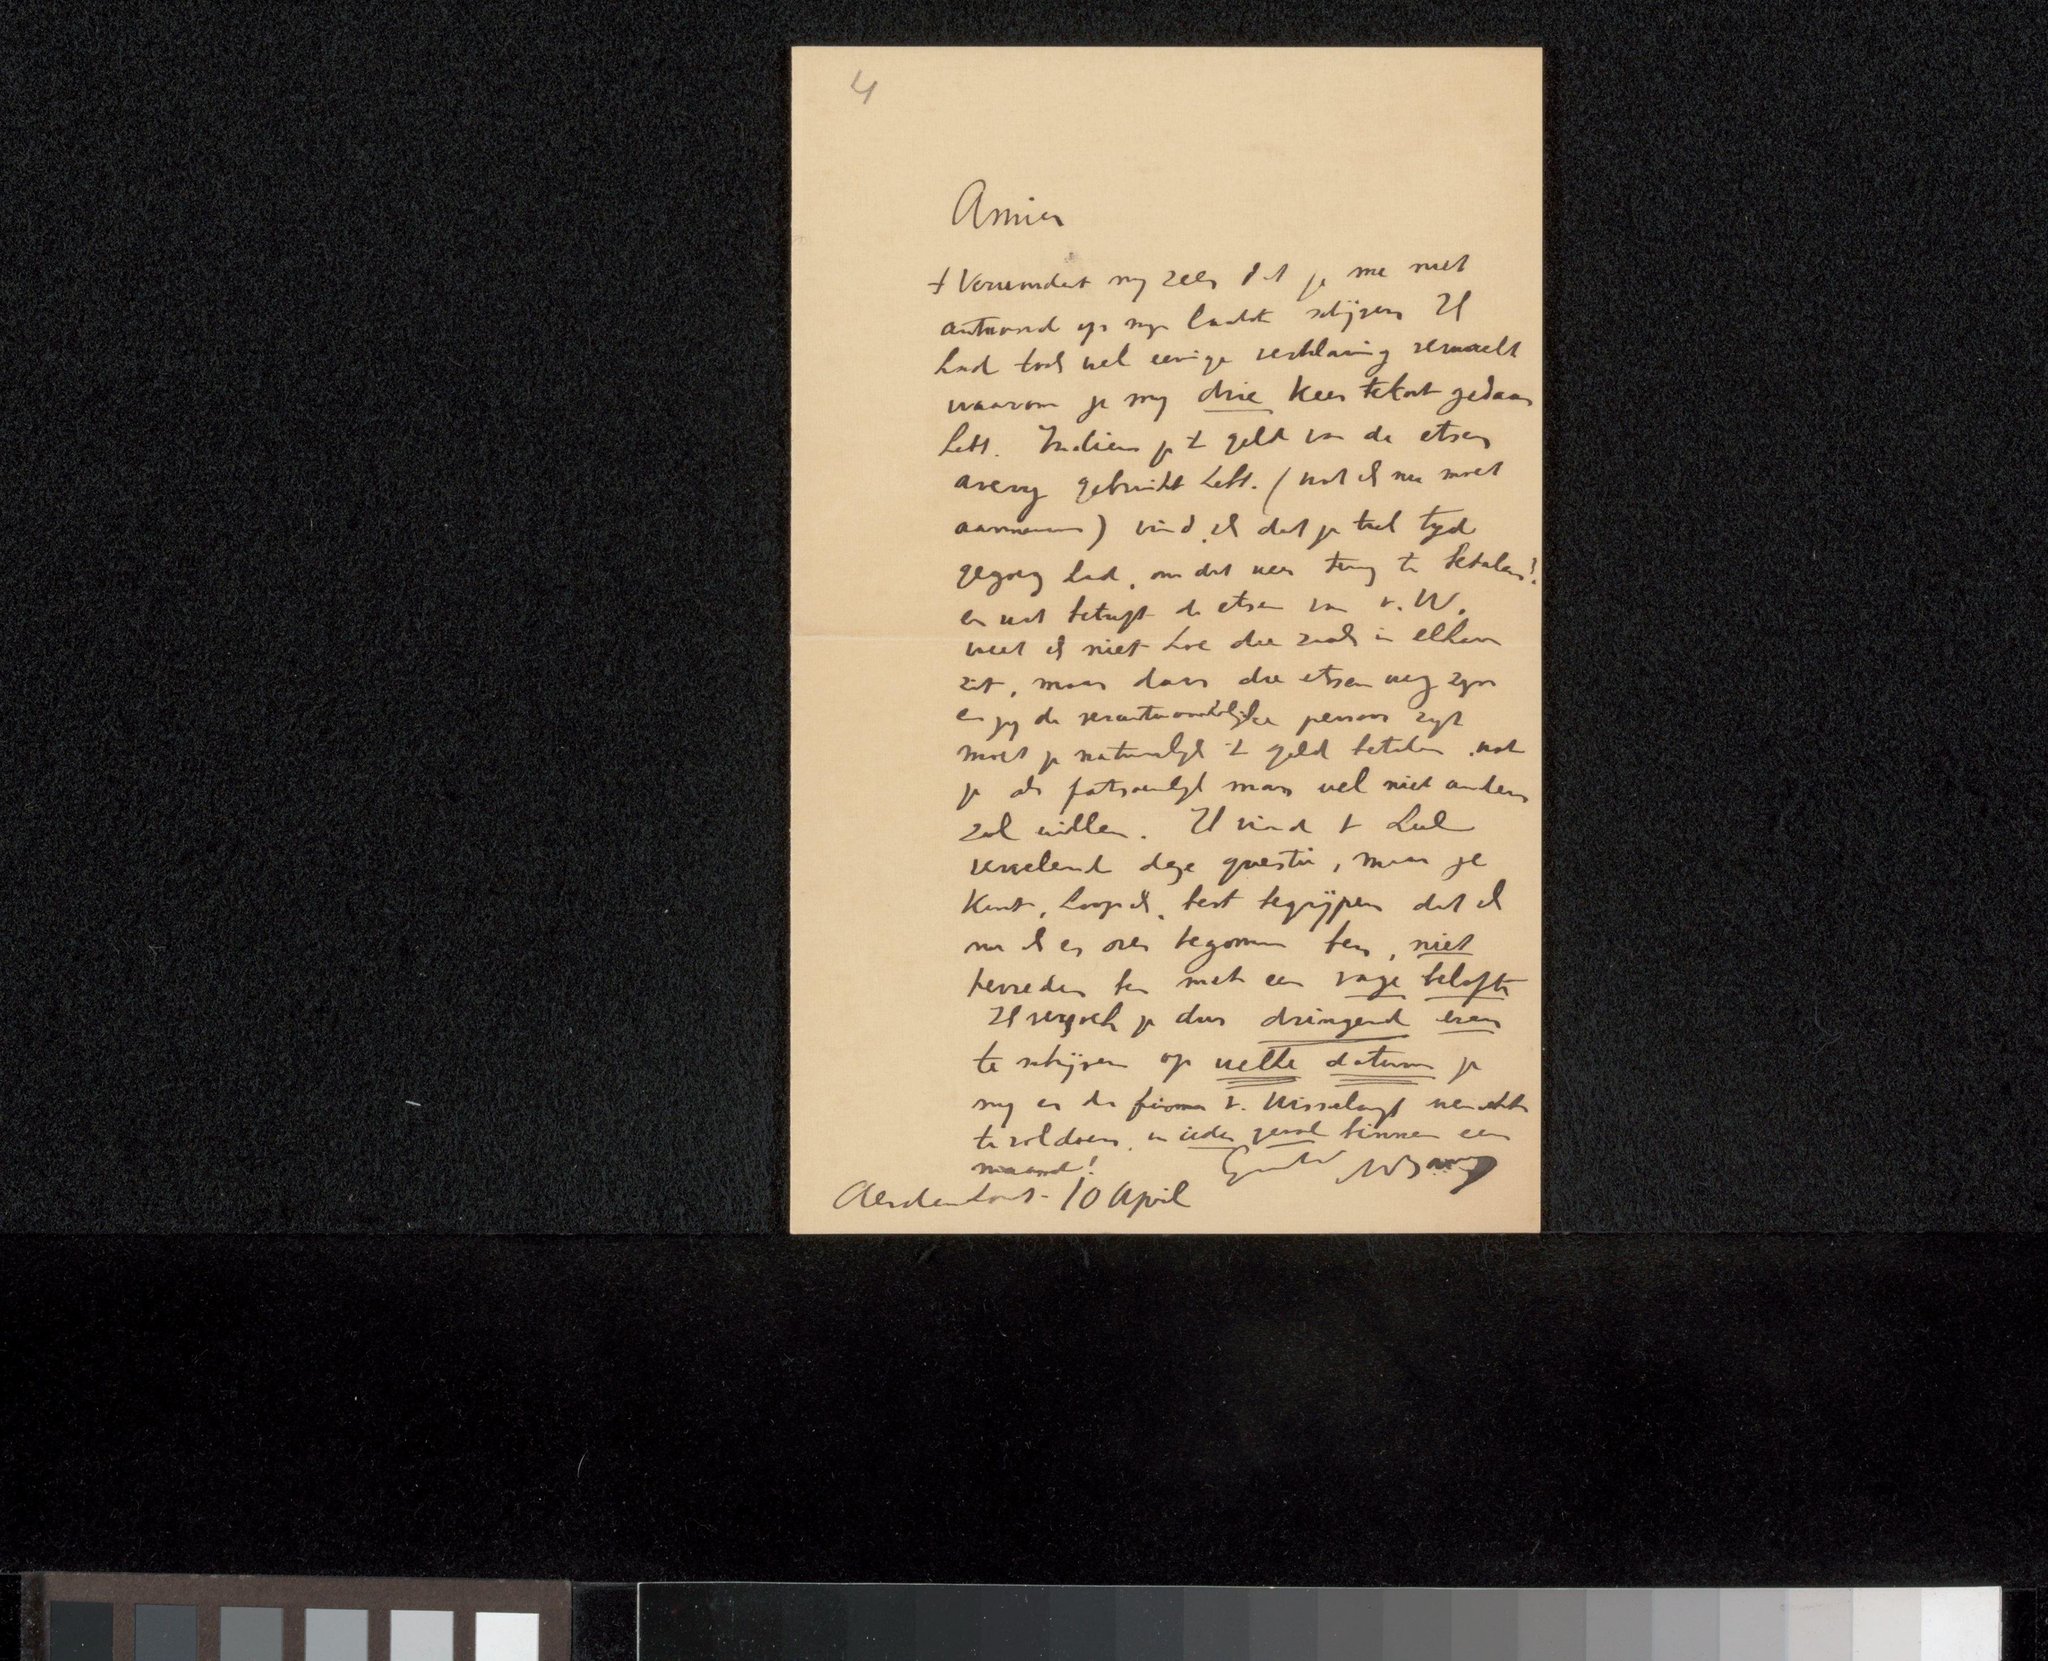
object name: letter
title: Brief aan Philip Zilcken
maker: marius bauer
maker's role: draughtsman, print maker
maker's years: 1867-1932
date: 1906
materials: ink, paper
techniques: pen, writing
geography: aerdenhout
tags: new york (city), samuel putnam avery, painter, philip zilcken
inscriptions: collector's mark: ‘RPK’